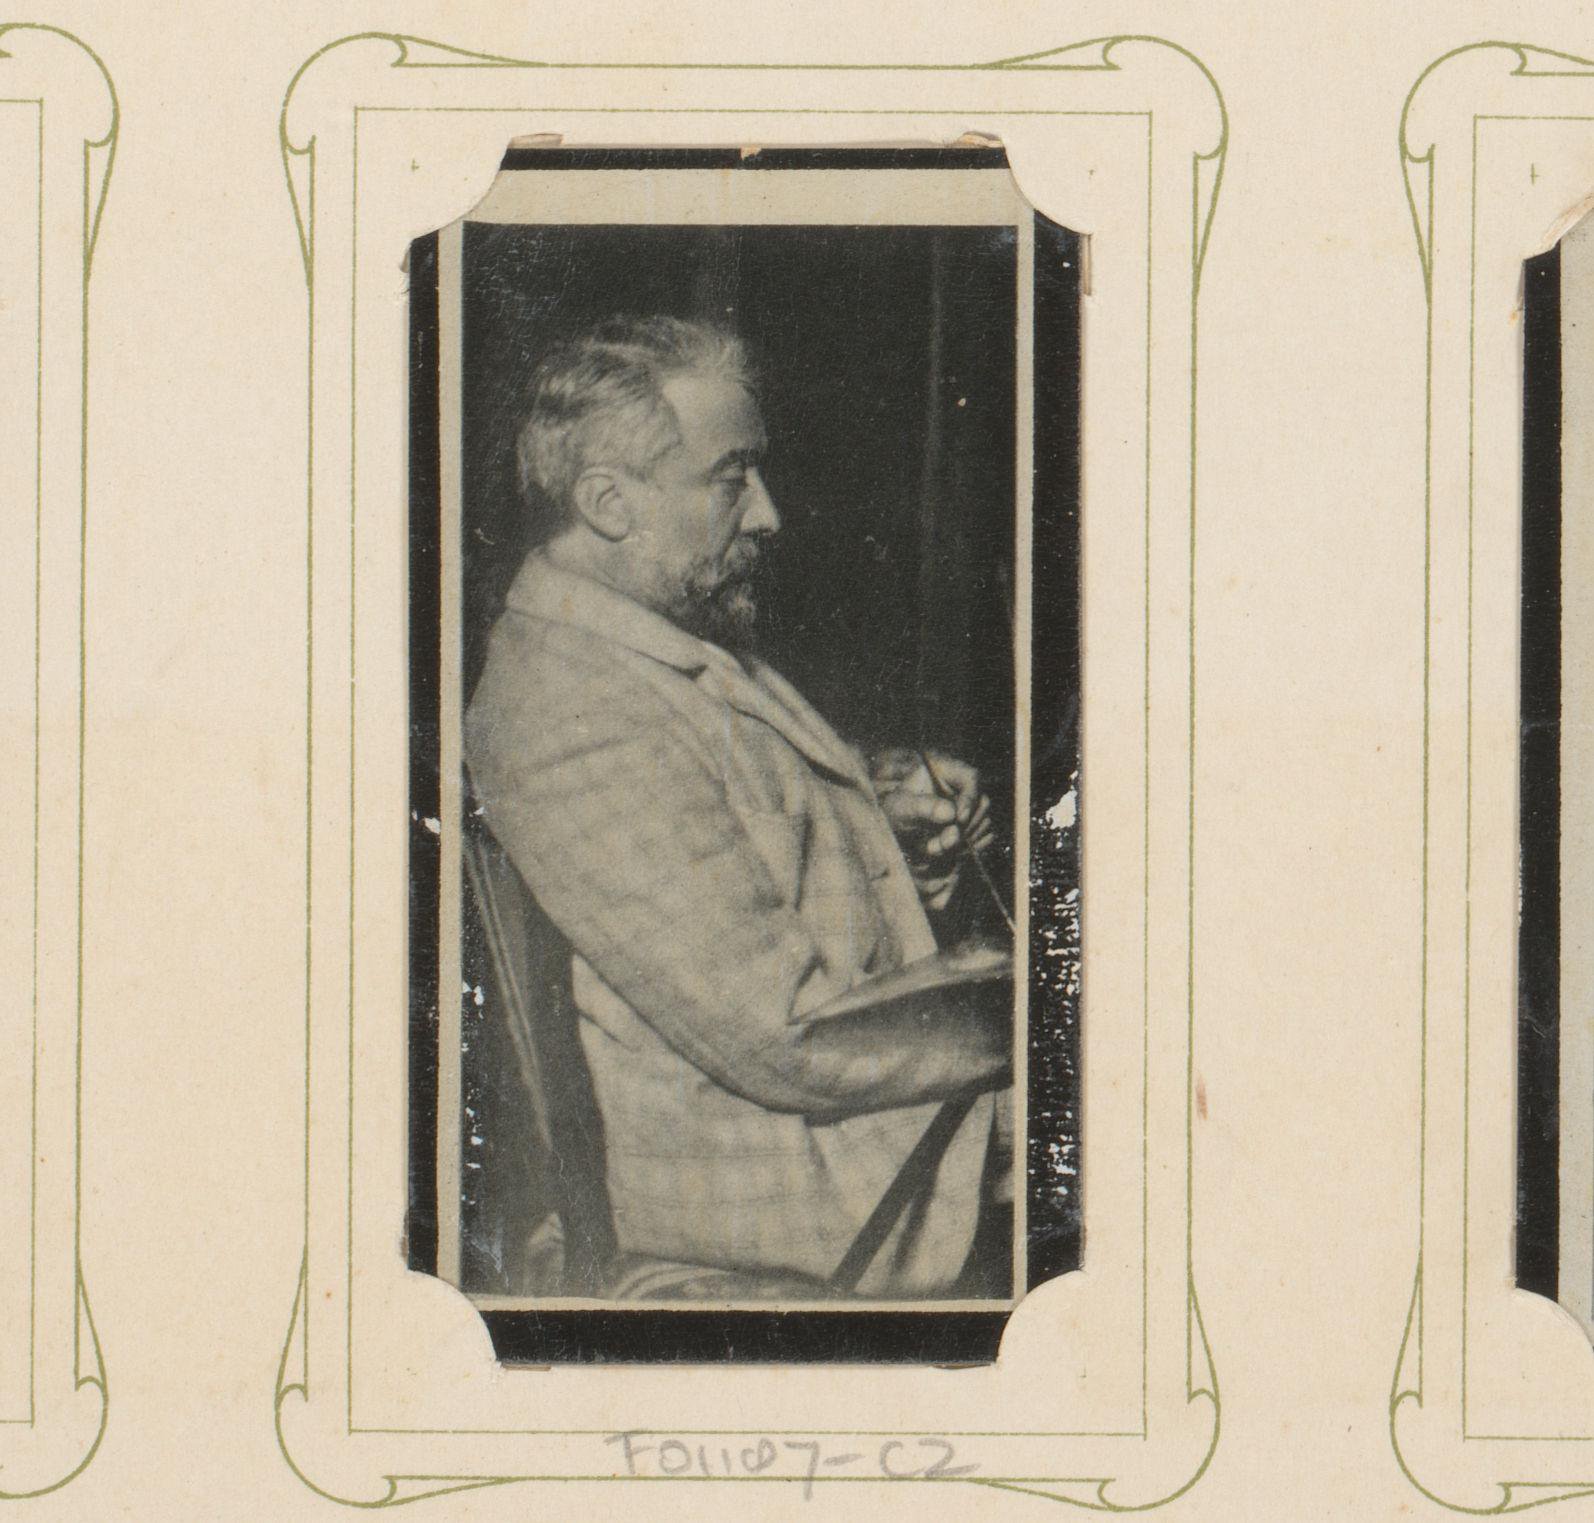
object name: album leaf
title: Portret van Bernardus Johannes Blommers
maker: Anonymous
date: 1905-1906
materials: paper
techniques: photograph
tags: print maker, draughtsman, bernardus johannes blommers, historical persons, portrait, self-portrait of painter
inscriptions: inscription: ‘No. 5./ Blommers.’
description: Deze prent maakt deel uit van een album.